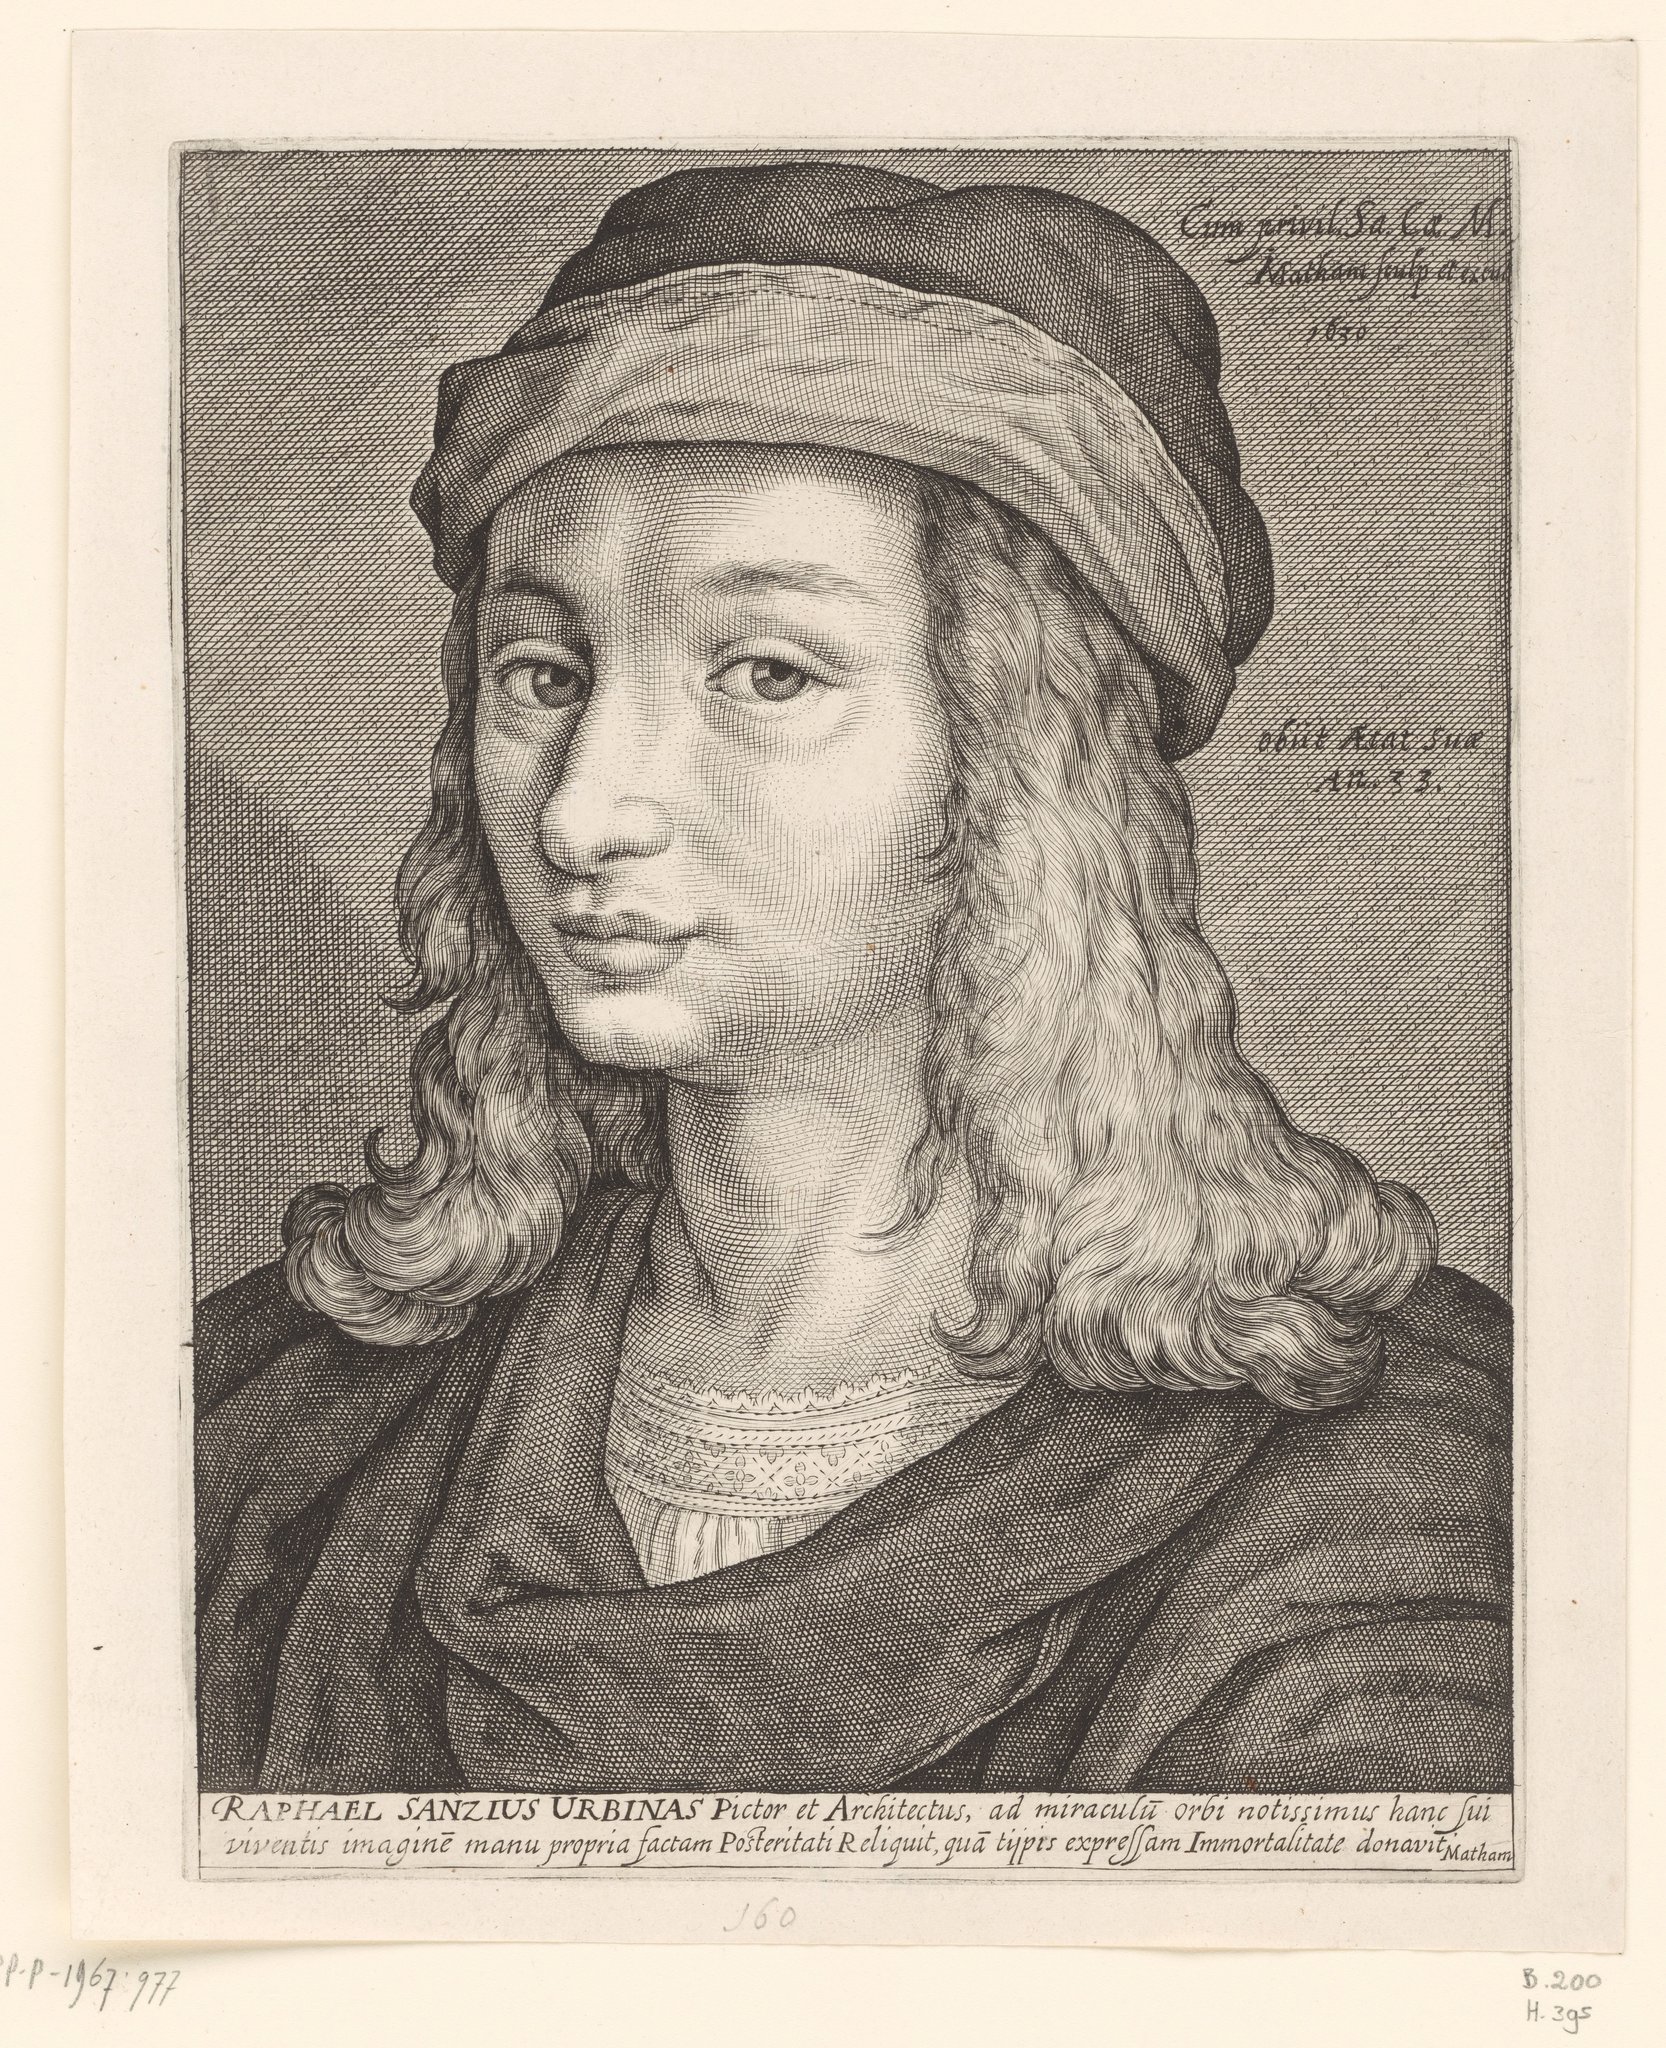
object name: print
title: Portret van Rafael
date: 1630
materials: paper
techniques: engraving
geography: haarlem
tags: rome, painter, rafaël, portrait, self-portrait of painter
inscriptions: collector's mark: Lugt 2760, collector's mark: Lugt 2228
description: Portret van de schilder Rafael op 33-jarige leeftijd.